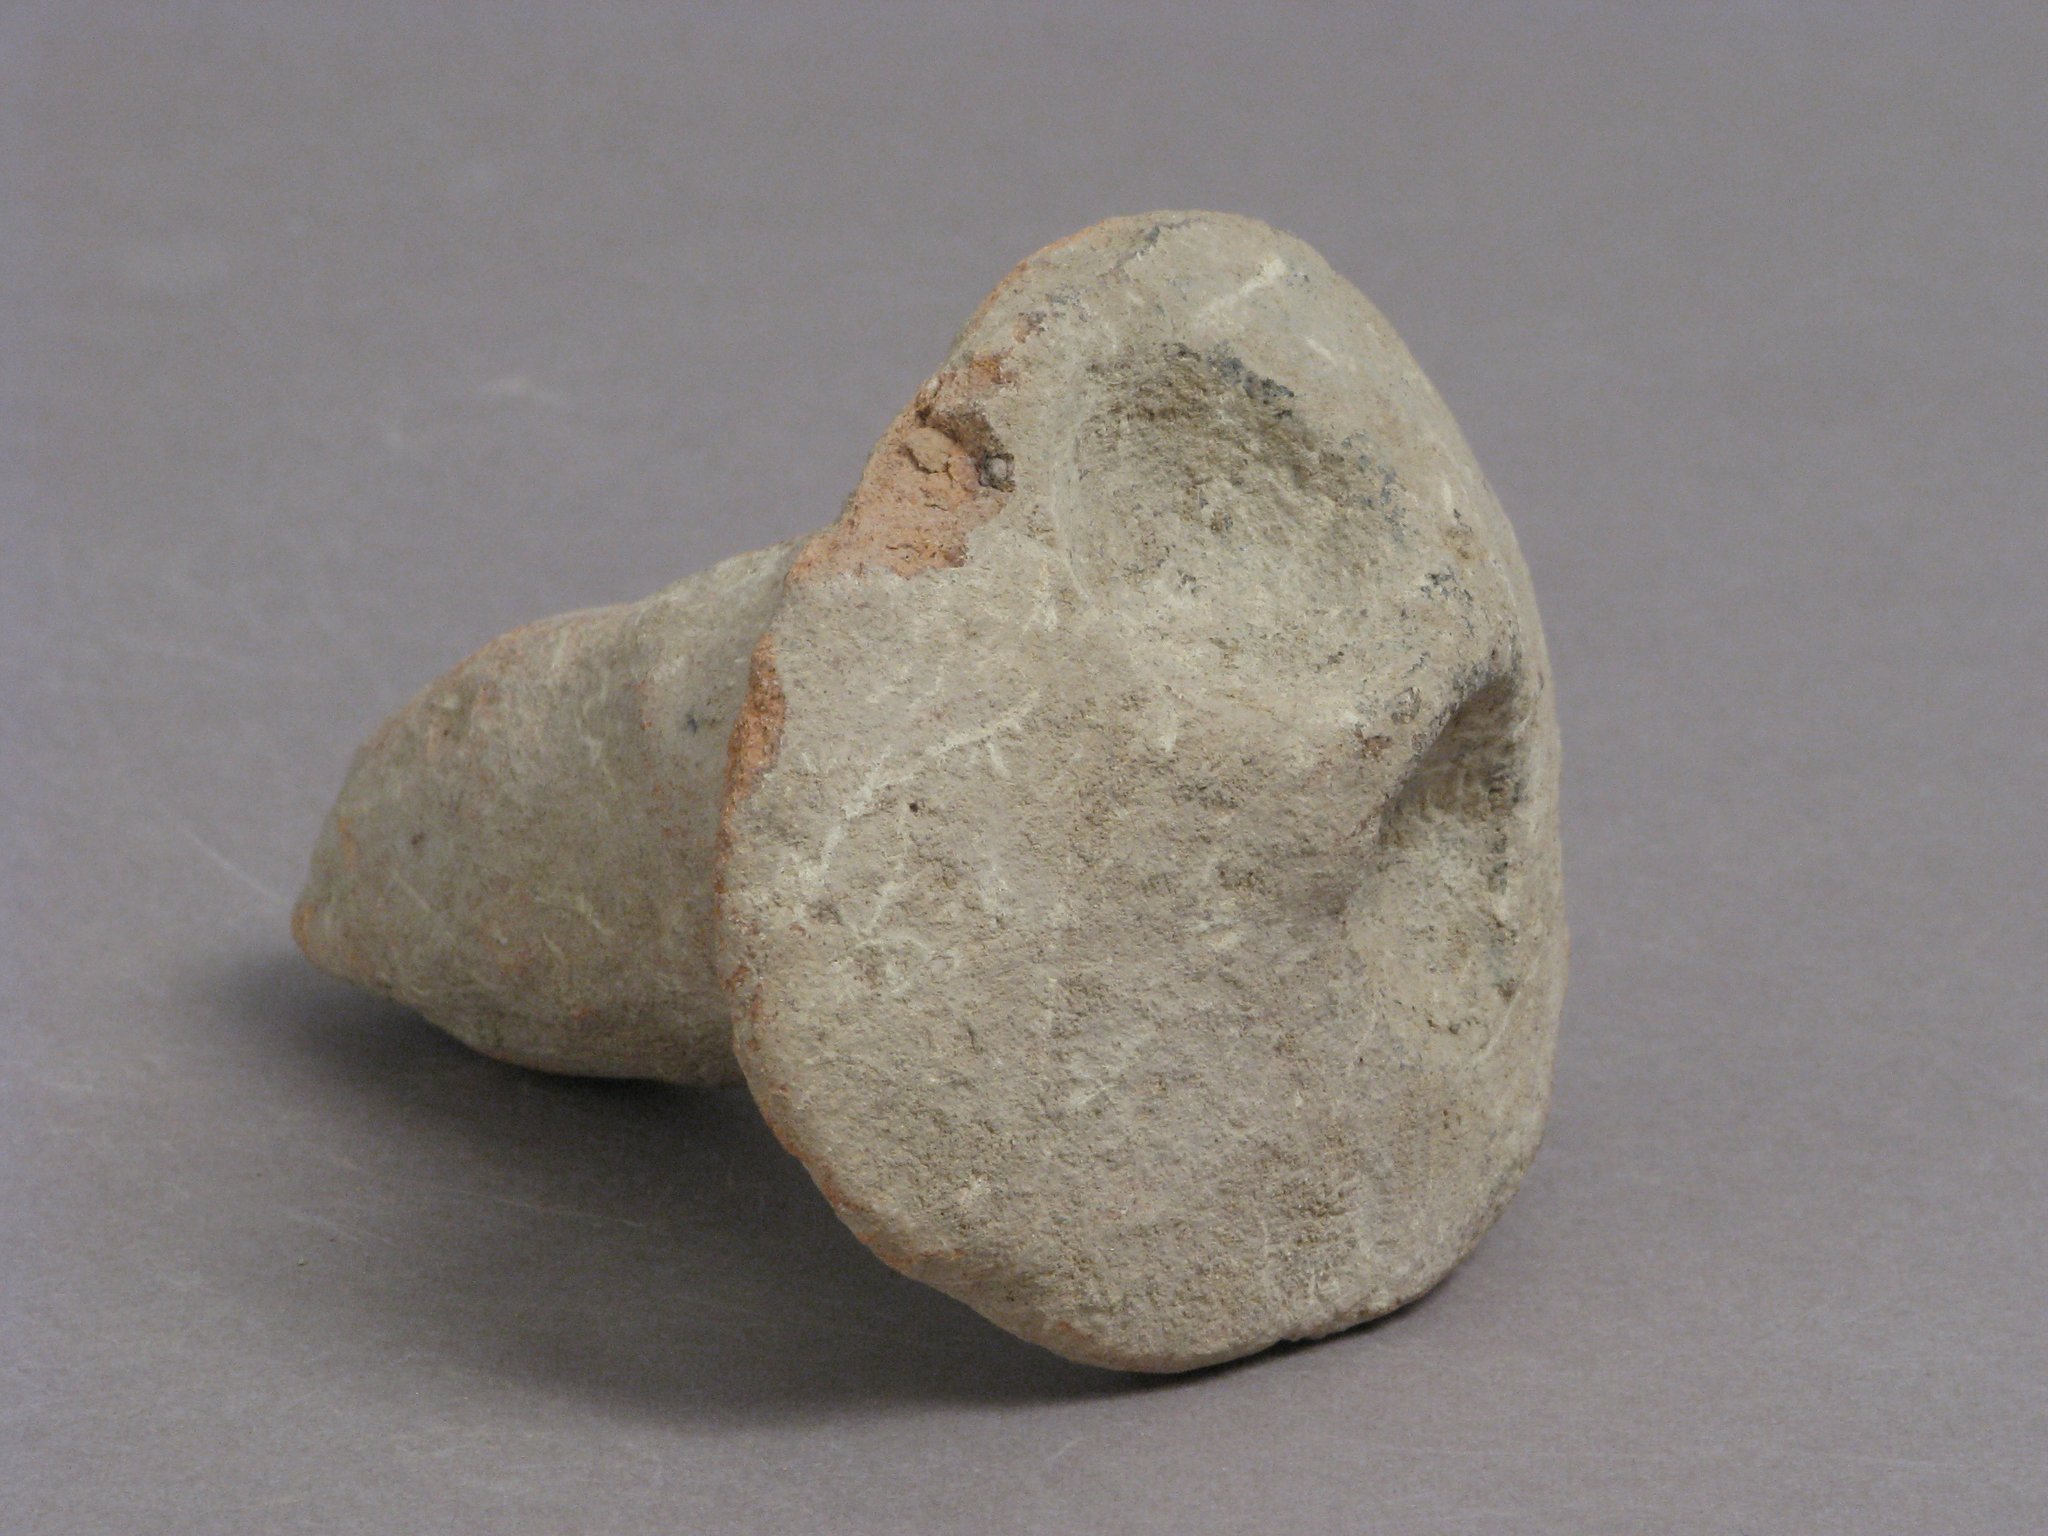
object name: lid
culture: coptic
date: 301-700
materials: earthenware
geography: egypt